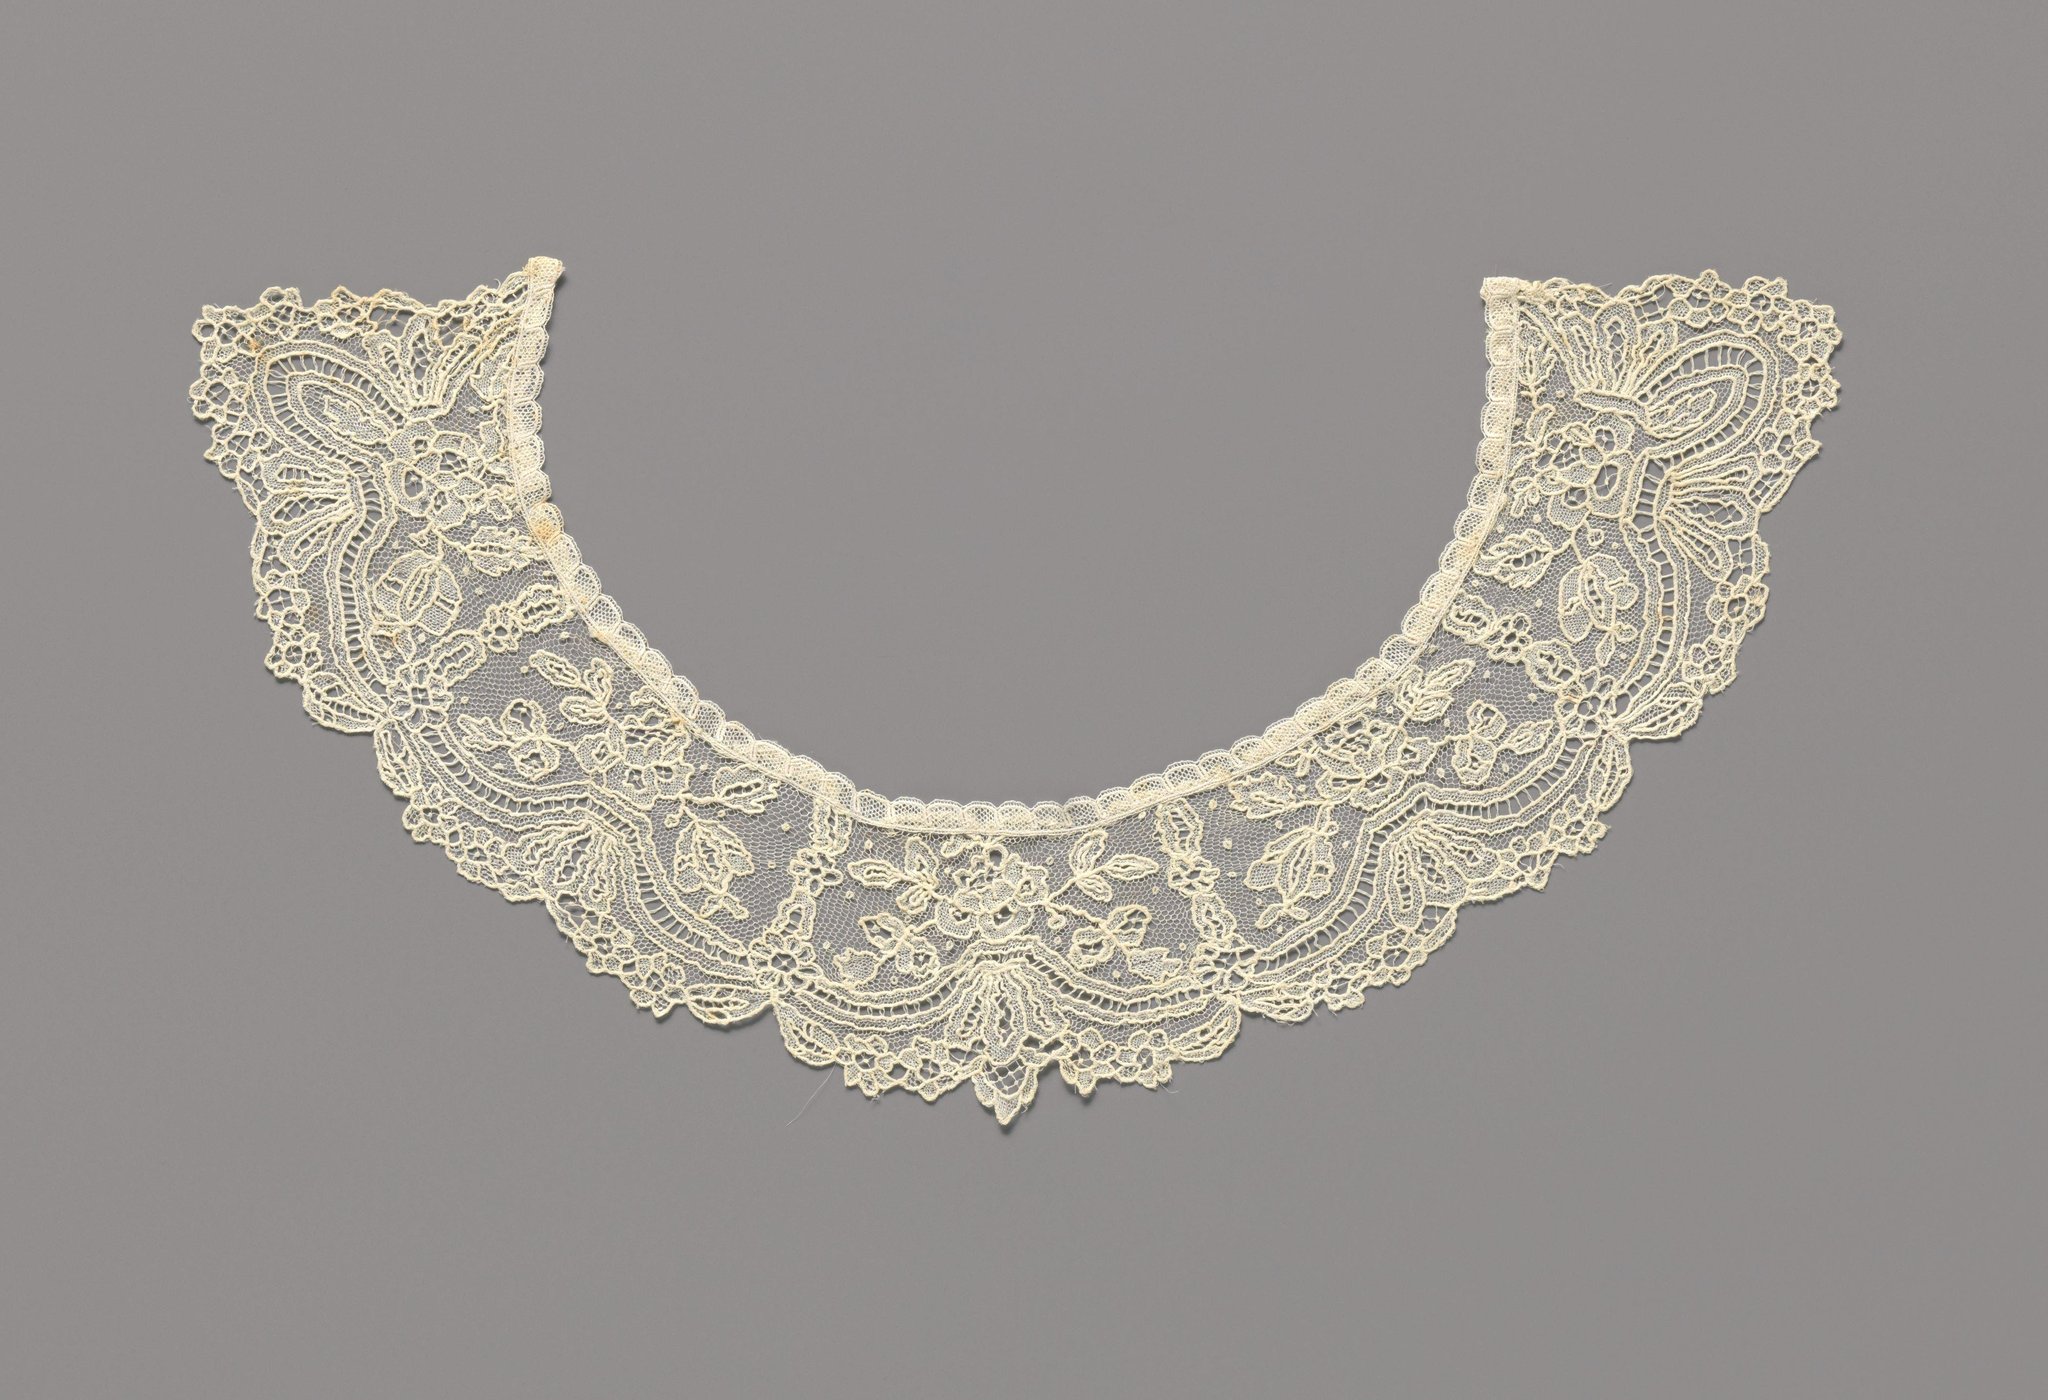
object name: collar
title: Kraag van naaldkant met symmetrisch patroon met vijf rozenvelden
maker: Anonymous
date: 1880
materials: linen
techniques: lace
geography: brussels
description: Kraag van naturelkleurig naaldkant: Brusselse gaaskant. Halfrond model. Het patroon heeft langs de rand een dubbele golvende lijn. Daarboven vijf velden met rozentakken en moesjes. Onder de golvende lijn, onder elke rozentak, een hangende kelkbloem tussen een bloemslinger van aaneengeschakelde rozetbloempjes. De schulpenrand komt voort uit het patroon met deze golven en de bloemslinger. Langs de bovenzijde of neklijn is een smal schulpenstrookje van machinale kant met boogjes genaaid.